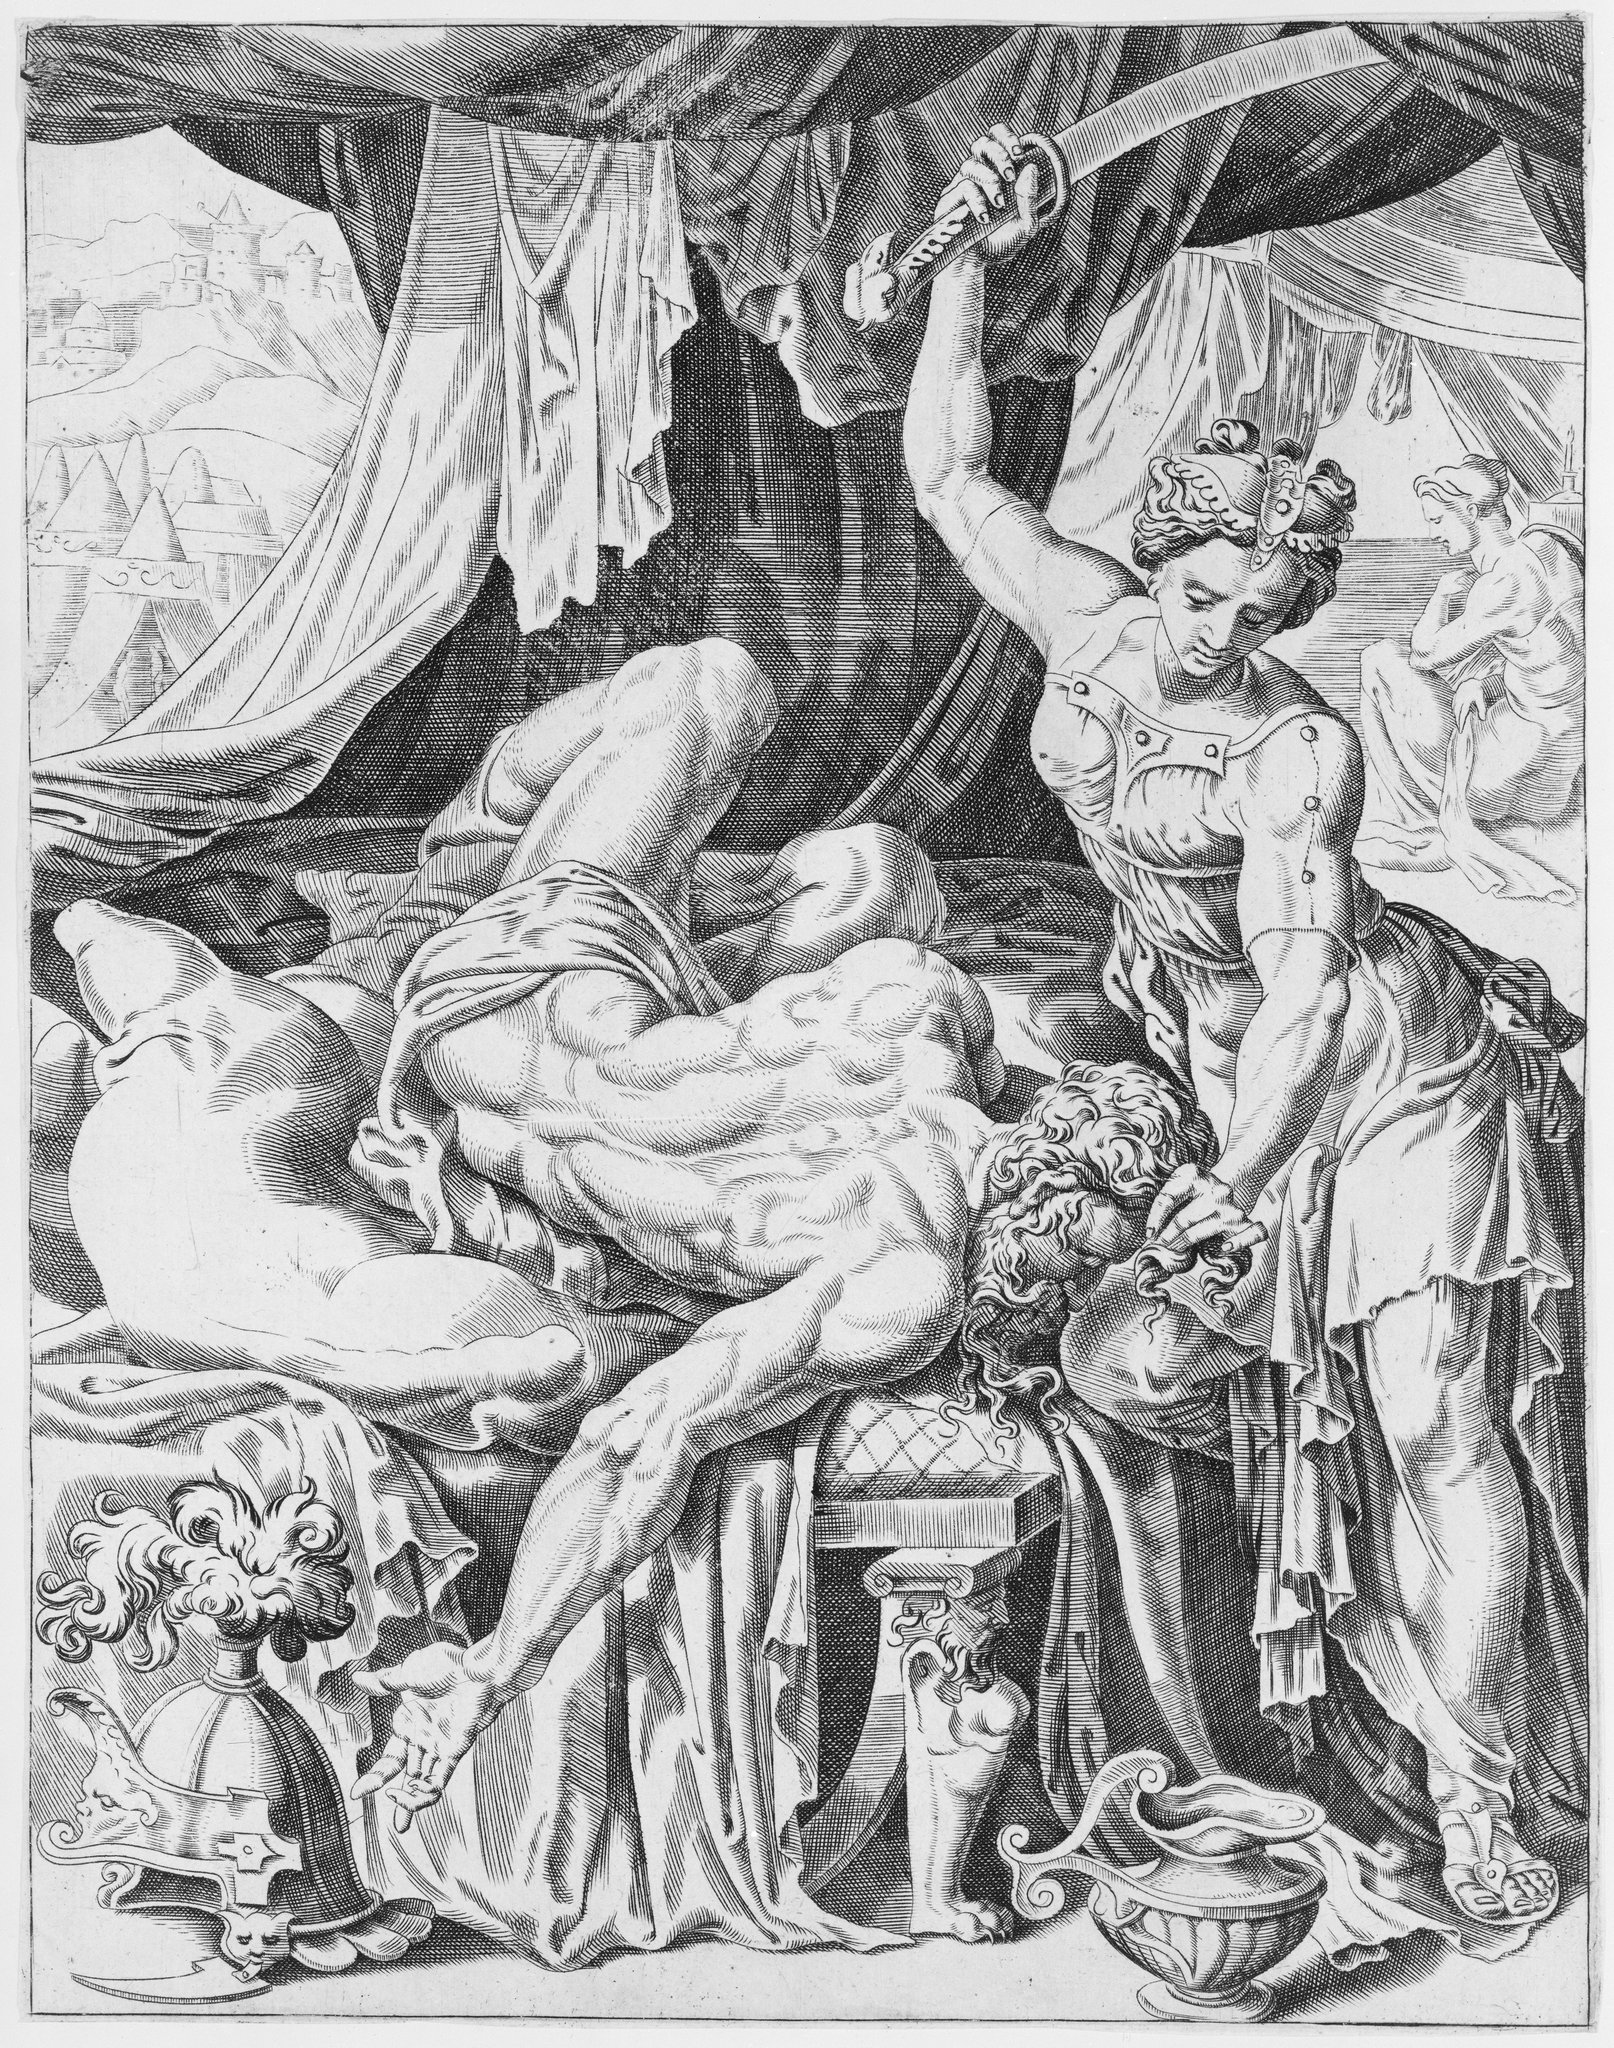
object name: print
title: Judith Slaying Holofernes, from The Power of Women, plate 5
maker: dirck volckertsz coornhert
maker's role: artist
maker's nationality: netherlandish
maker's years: 1519-1590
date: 1551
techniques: engraving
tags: swords,men,women